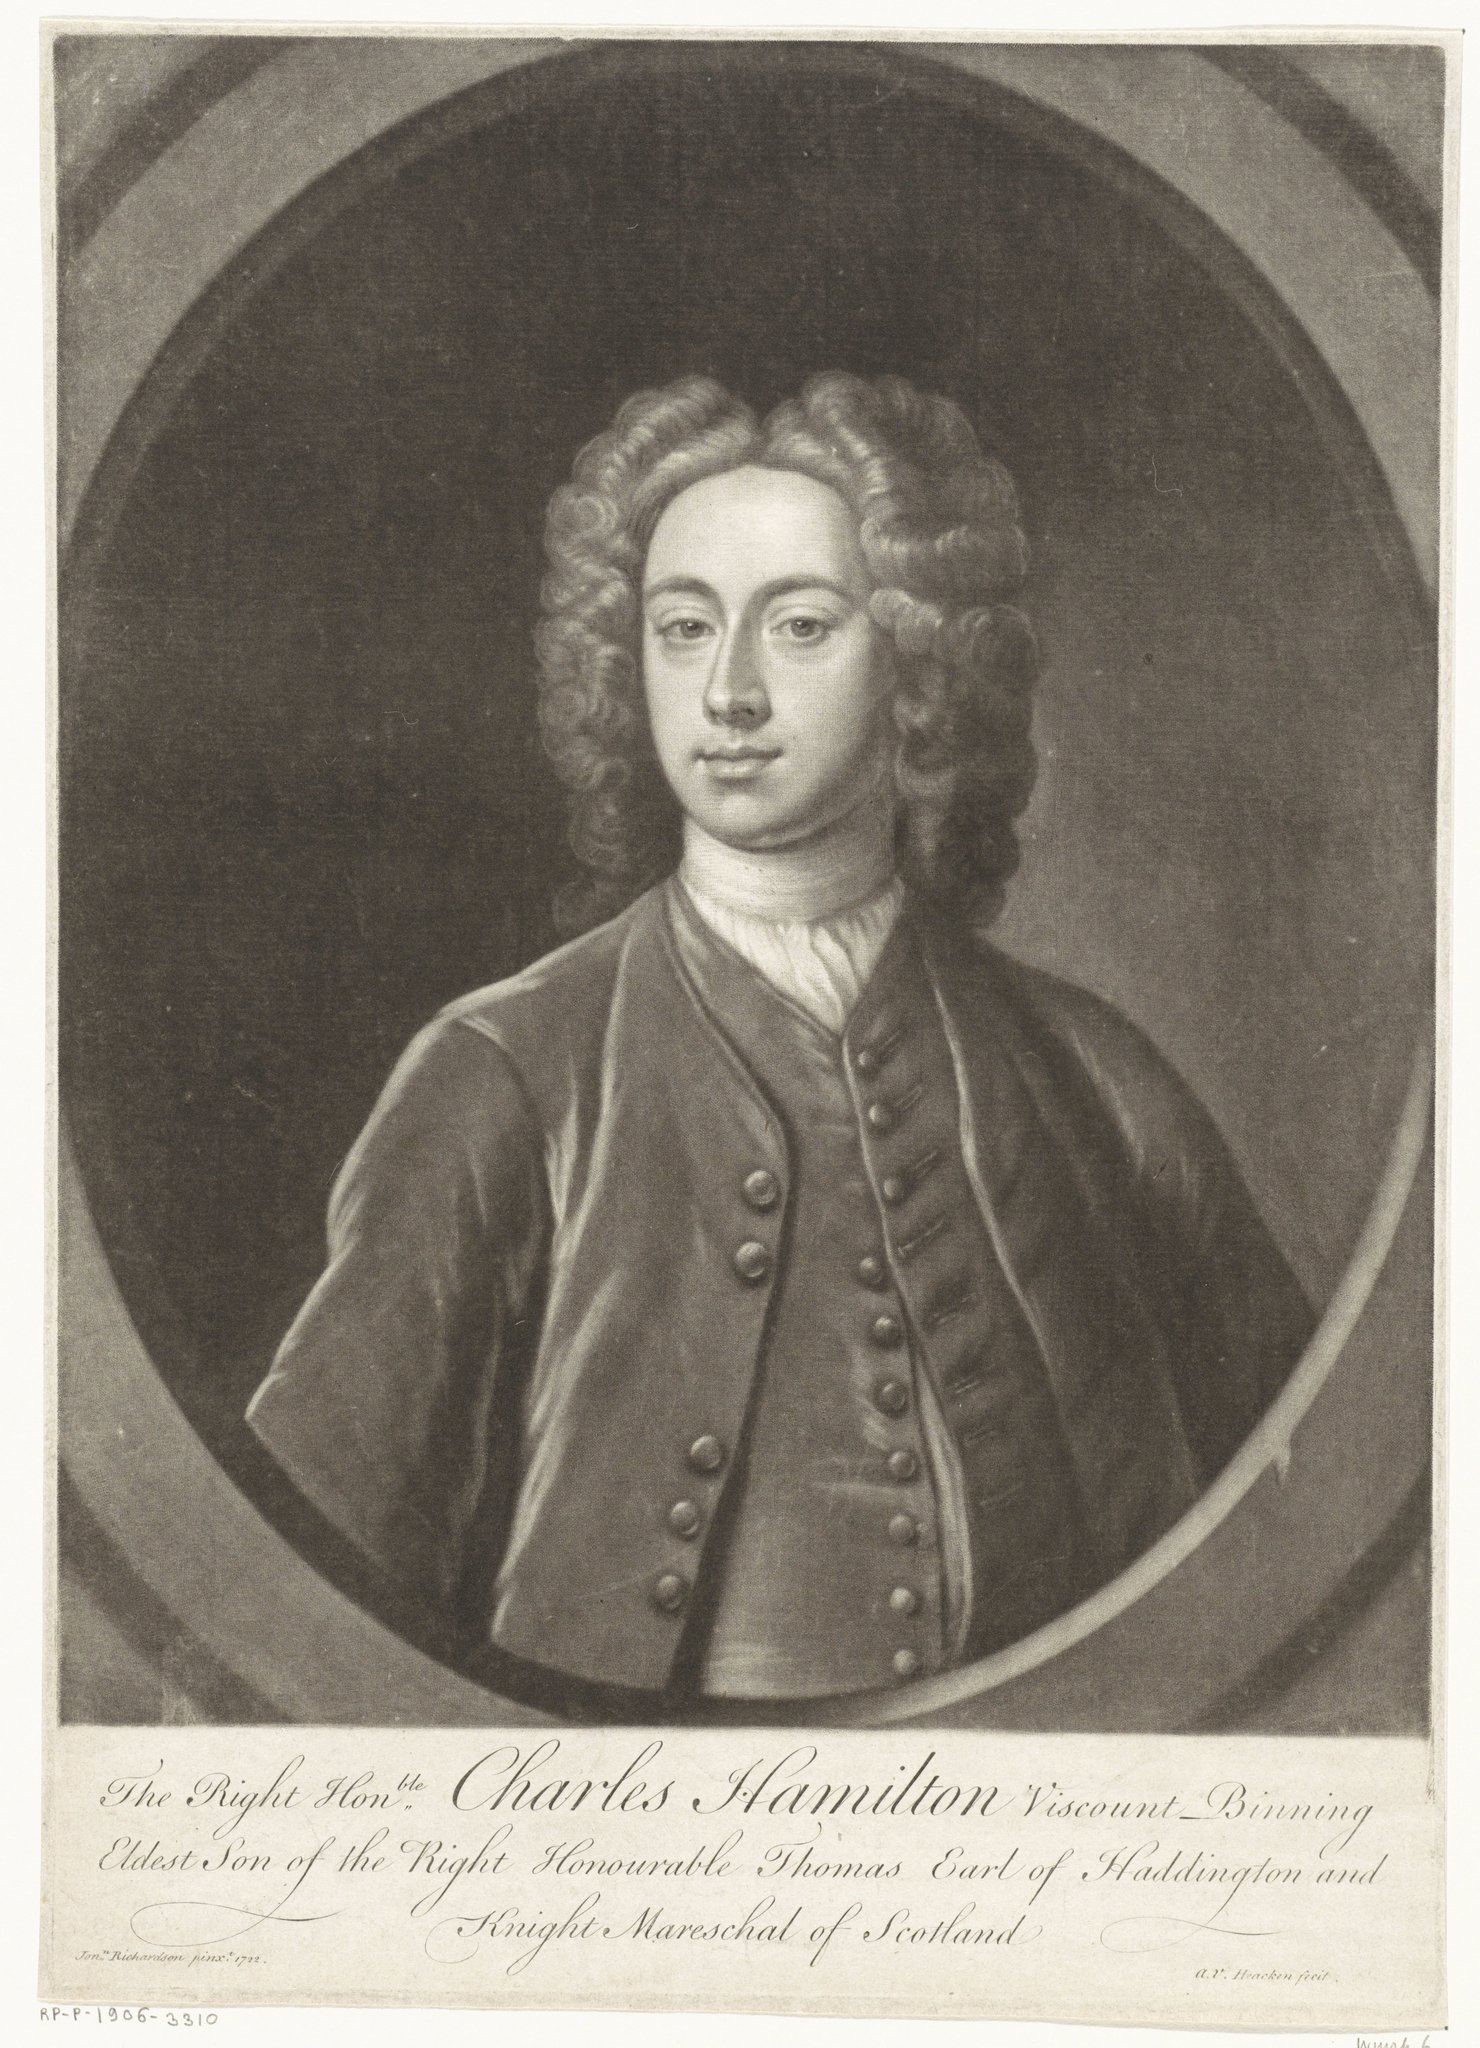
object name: print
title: Portret van Charles Hamilton Binning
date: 1735-1757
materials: paper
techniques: engraving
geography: london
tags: wig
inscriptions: collector's mark: Lugt 2228